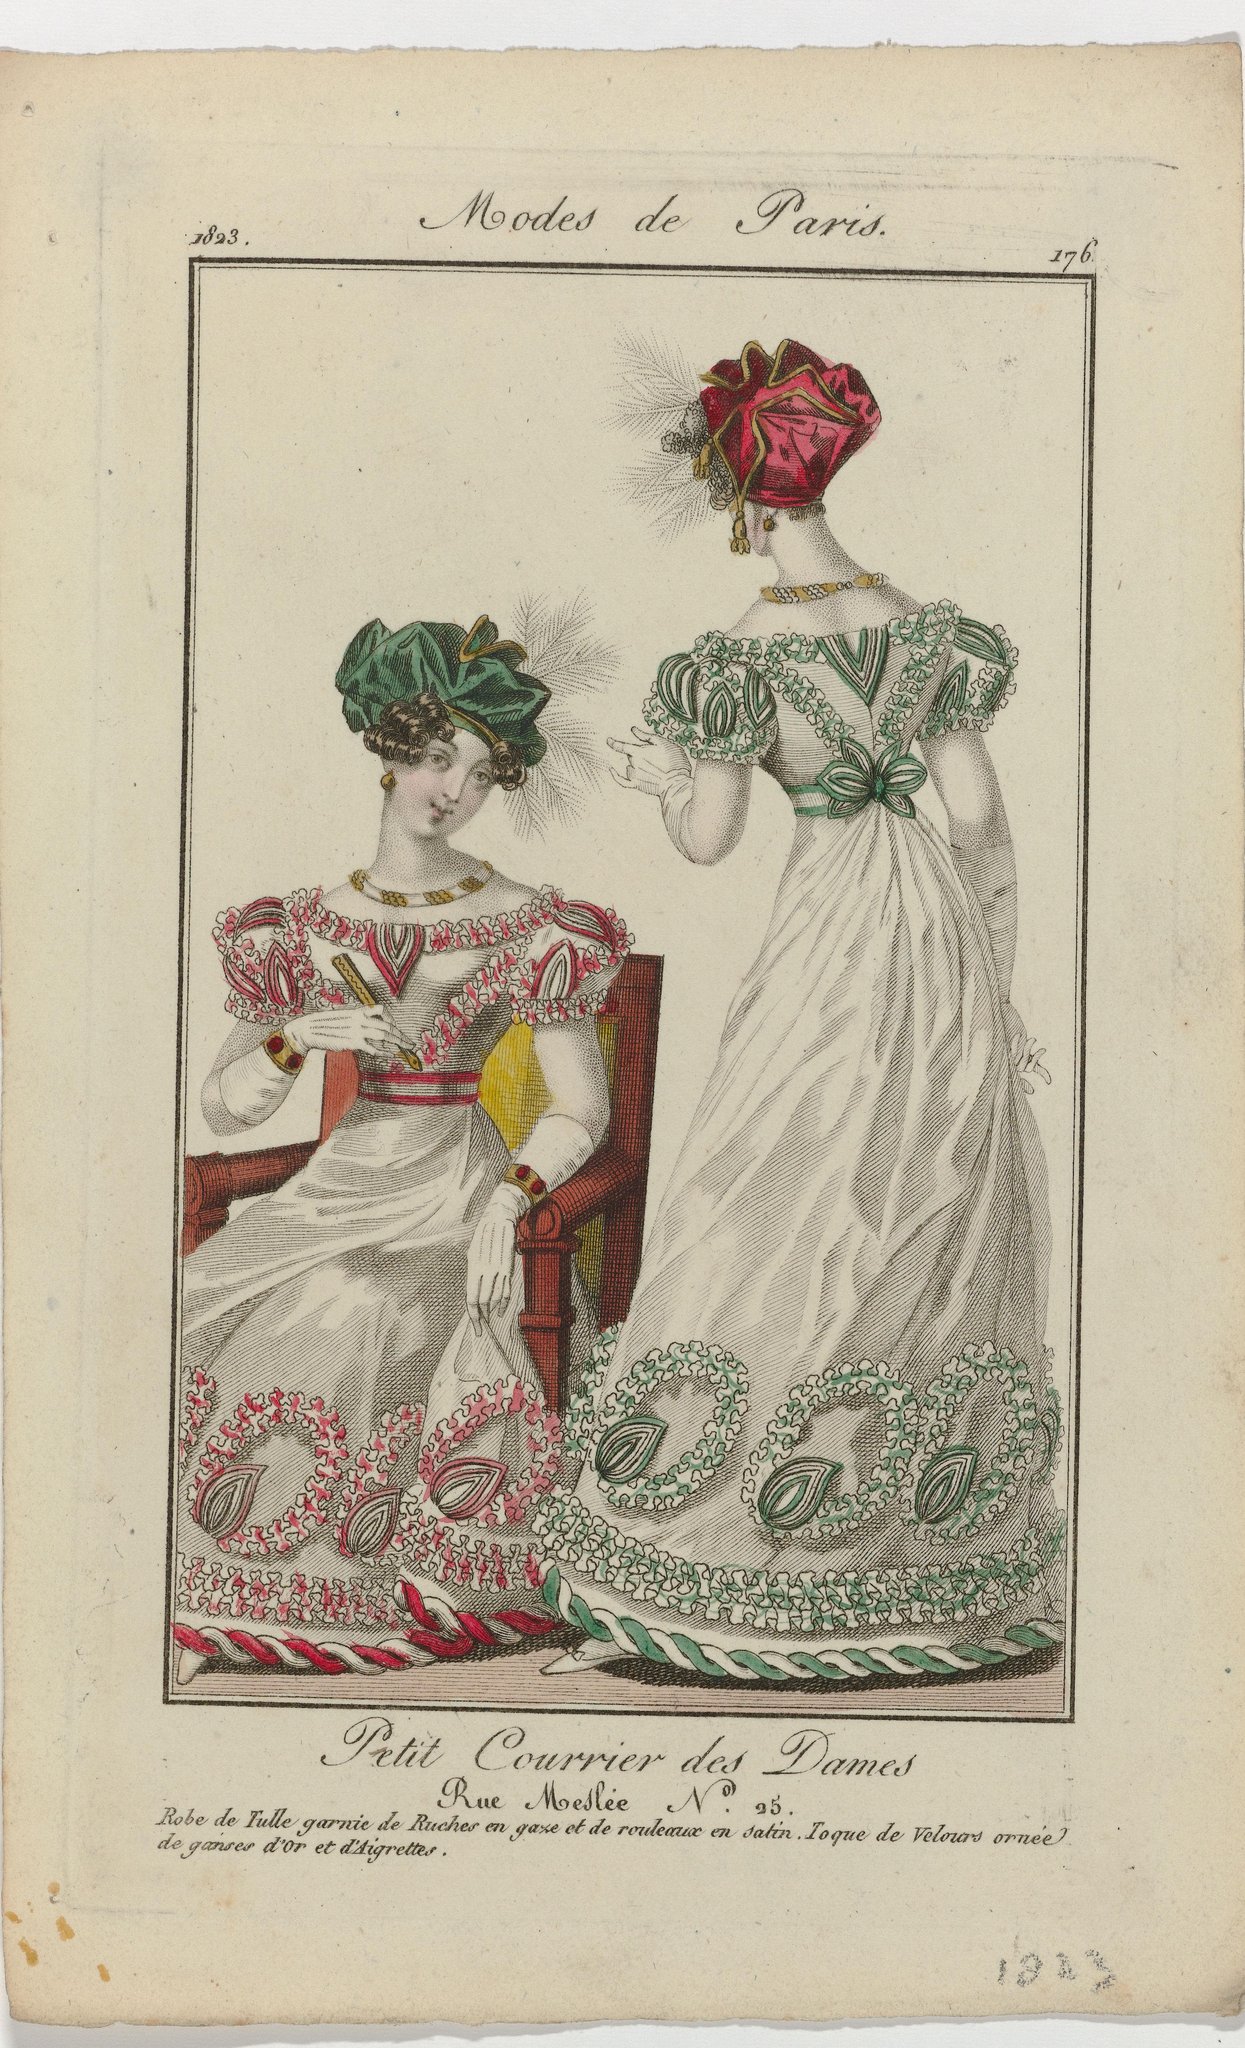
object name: fashion print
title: Petit Courrier des Dames, 1823, No. 176 : Robe de Tulle garnie de Ruches (...)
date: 1823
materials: paper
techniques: engraving, hand coloring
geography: paris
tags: ear-rings (+ women's clothes), head-gear: toque (+ women's clothes), gloves, mittens (long gloves) (+ women's clothes), ornamental parts of clothing (+ women's clothes), fashion plates, shoes, sandals (+ women's clothes), dress, gown (+ women's clothes), bracelet, wristlet (+ women's clothes), necklace (+ women's clothes)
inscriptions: title: ‘Modes de Paris.’, caption: ‘Riobe de Tulle garnie de Ruches en gaze et de rouleaux en satin. Toque de Velours ornée de ganses d'Or et d'Aigrettes.’, address: ‘Rue Meslée No.25.’, title: ‘Petit Courrier des Dames.’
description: Vrouw, zittend in een armstoel, gekleed in een japon van tule, afgezet met ruches van tule en rouleaux van satijn. Op het hoofd een toque van fluweel, versierd goudkleurige galon en enkele aigrettes. Verdere accessoires: oorbel in het rechteroor, collier, ceintuur, waaier, lange handschoenen, armbanden om beide polsen. Rechts een staande vrouw, op de rug gezien, gekleed in eenzelfde japon. Prent uit het modetijdschrift Petit Courrier des Dames (1821-1868).